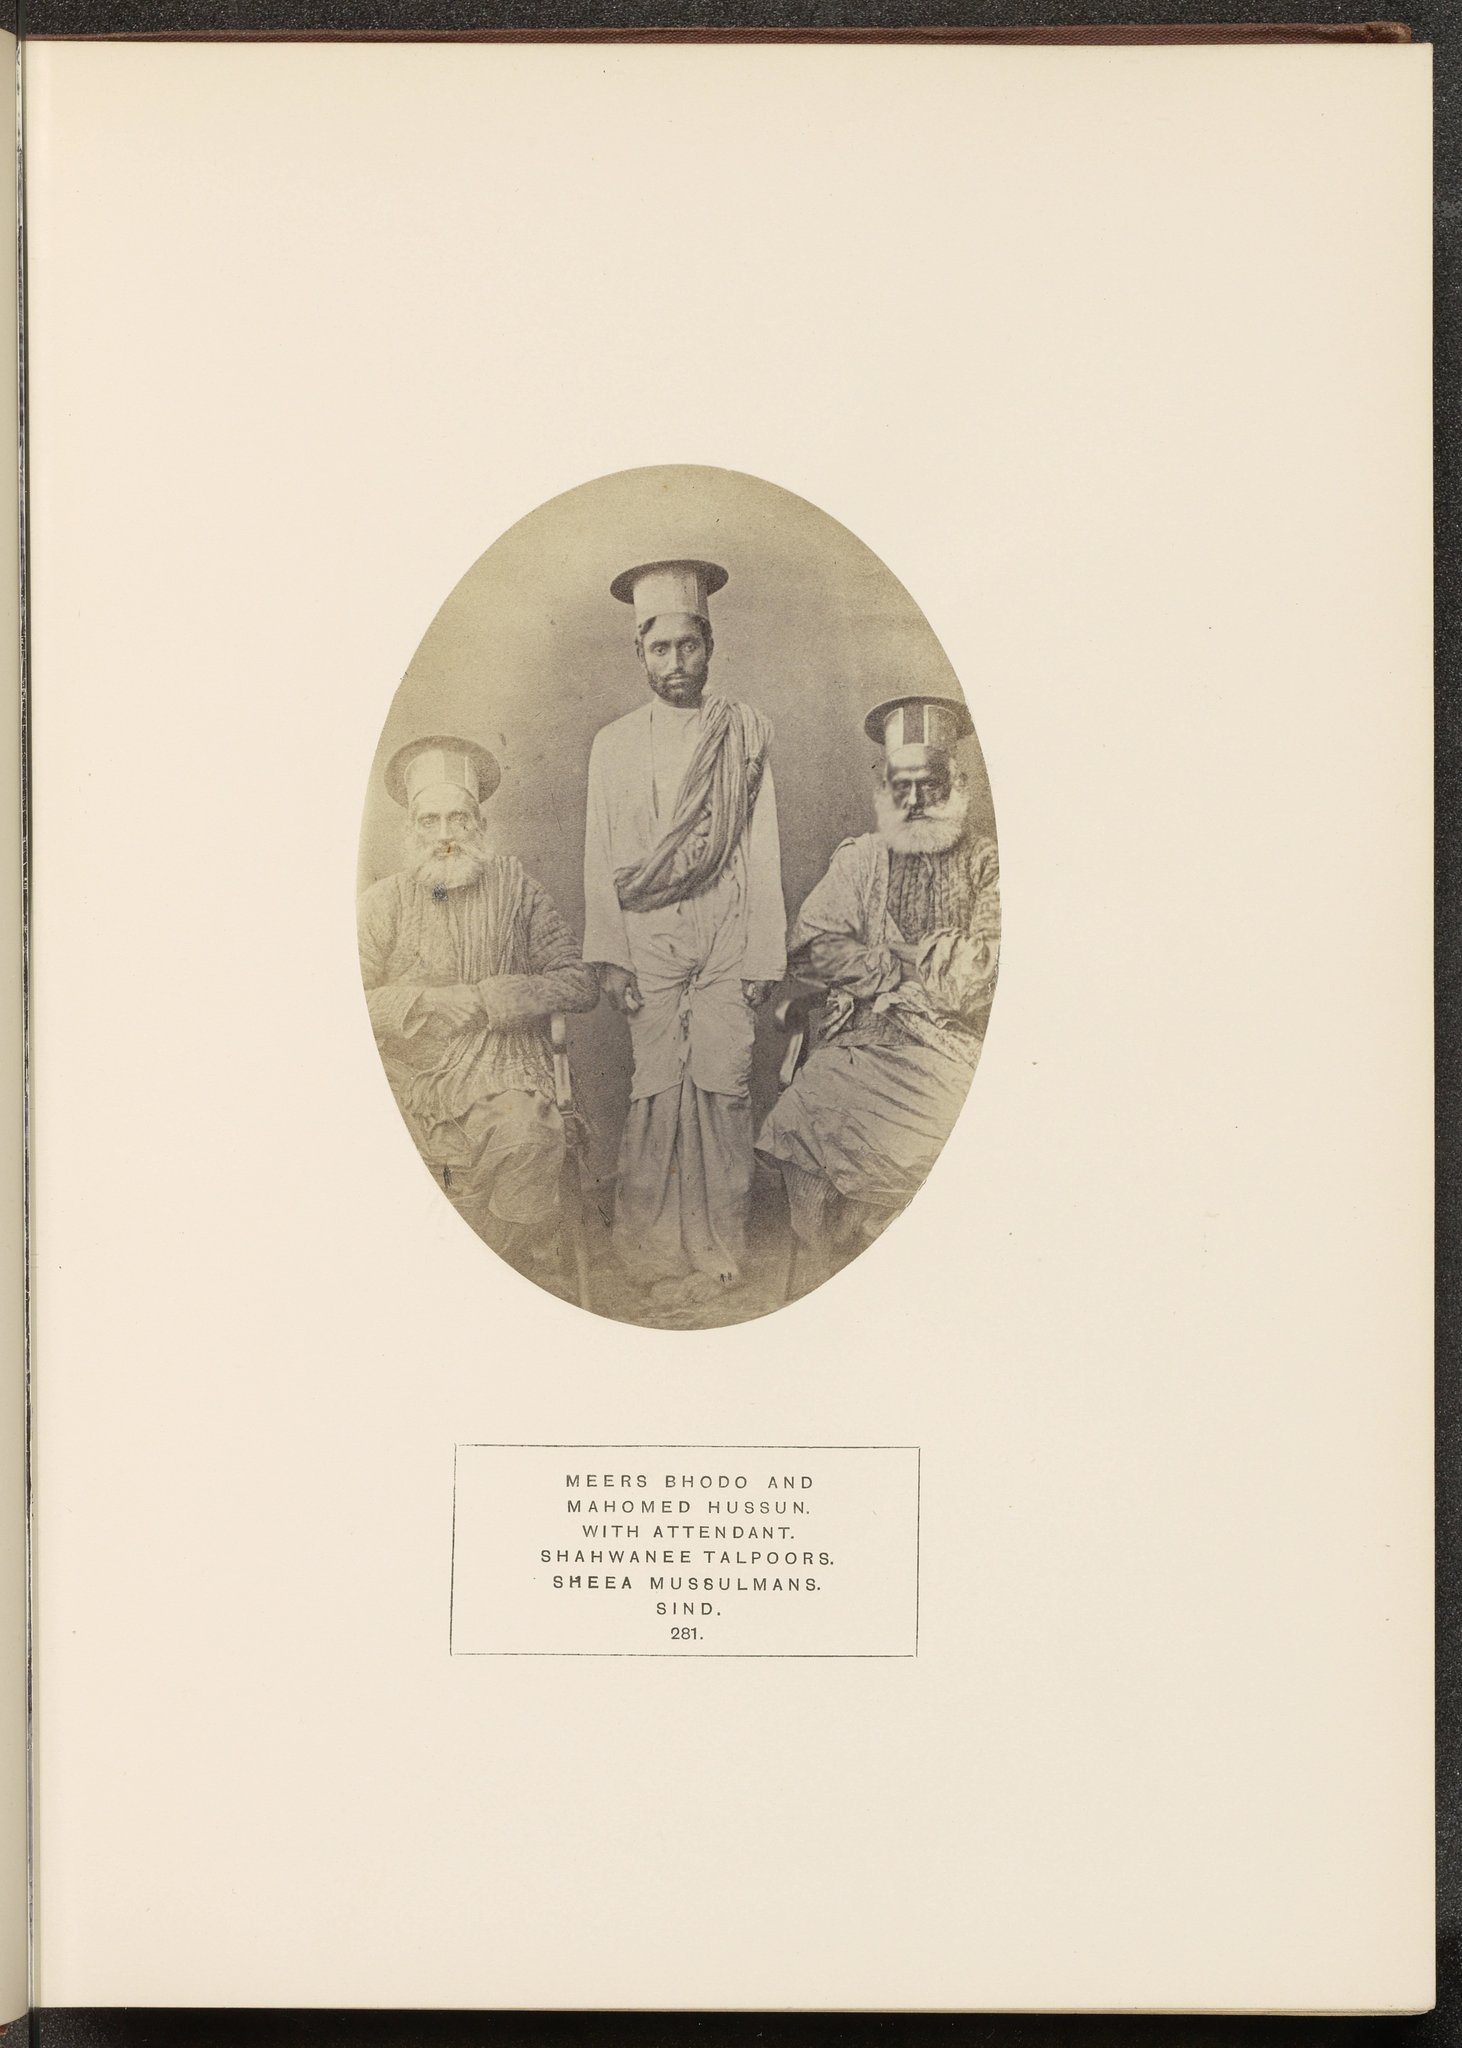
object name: page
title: Portrait of Mir Bhodo and Mir Mahomed Hussun with an assitant, Sindh, Pakistan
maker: henry charles baskerville tanner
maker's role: fotograaf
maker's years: 1835-1898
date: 1862-1872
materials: photographic support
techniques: albumen print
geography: sindh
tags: ruler, sovereign, human races; peoples; nationalities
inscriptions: number: ‘281.’, inscription: ‘MEERS BHODO AND MAHOMED HUSSUN./ WITH ATTENDANT./ SHAHWANEER TALPOORS./ SHEEA MUSSULMANS./ SIND.’